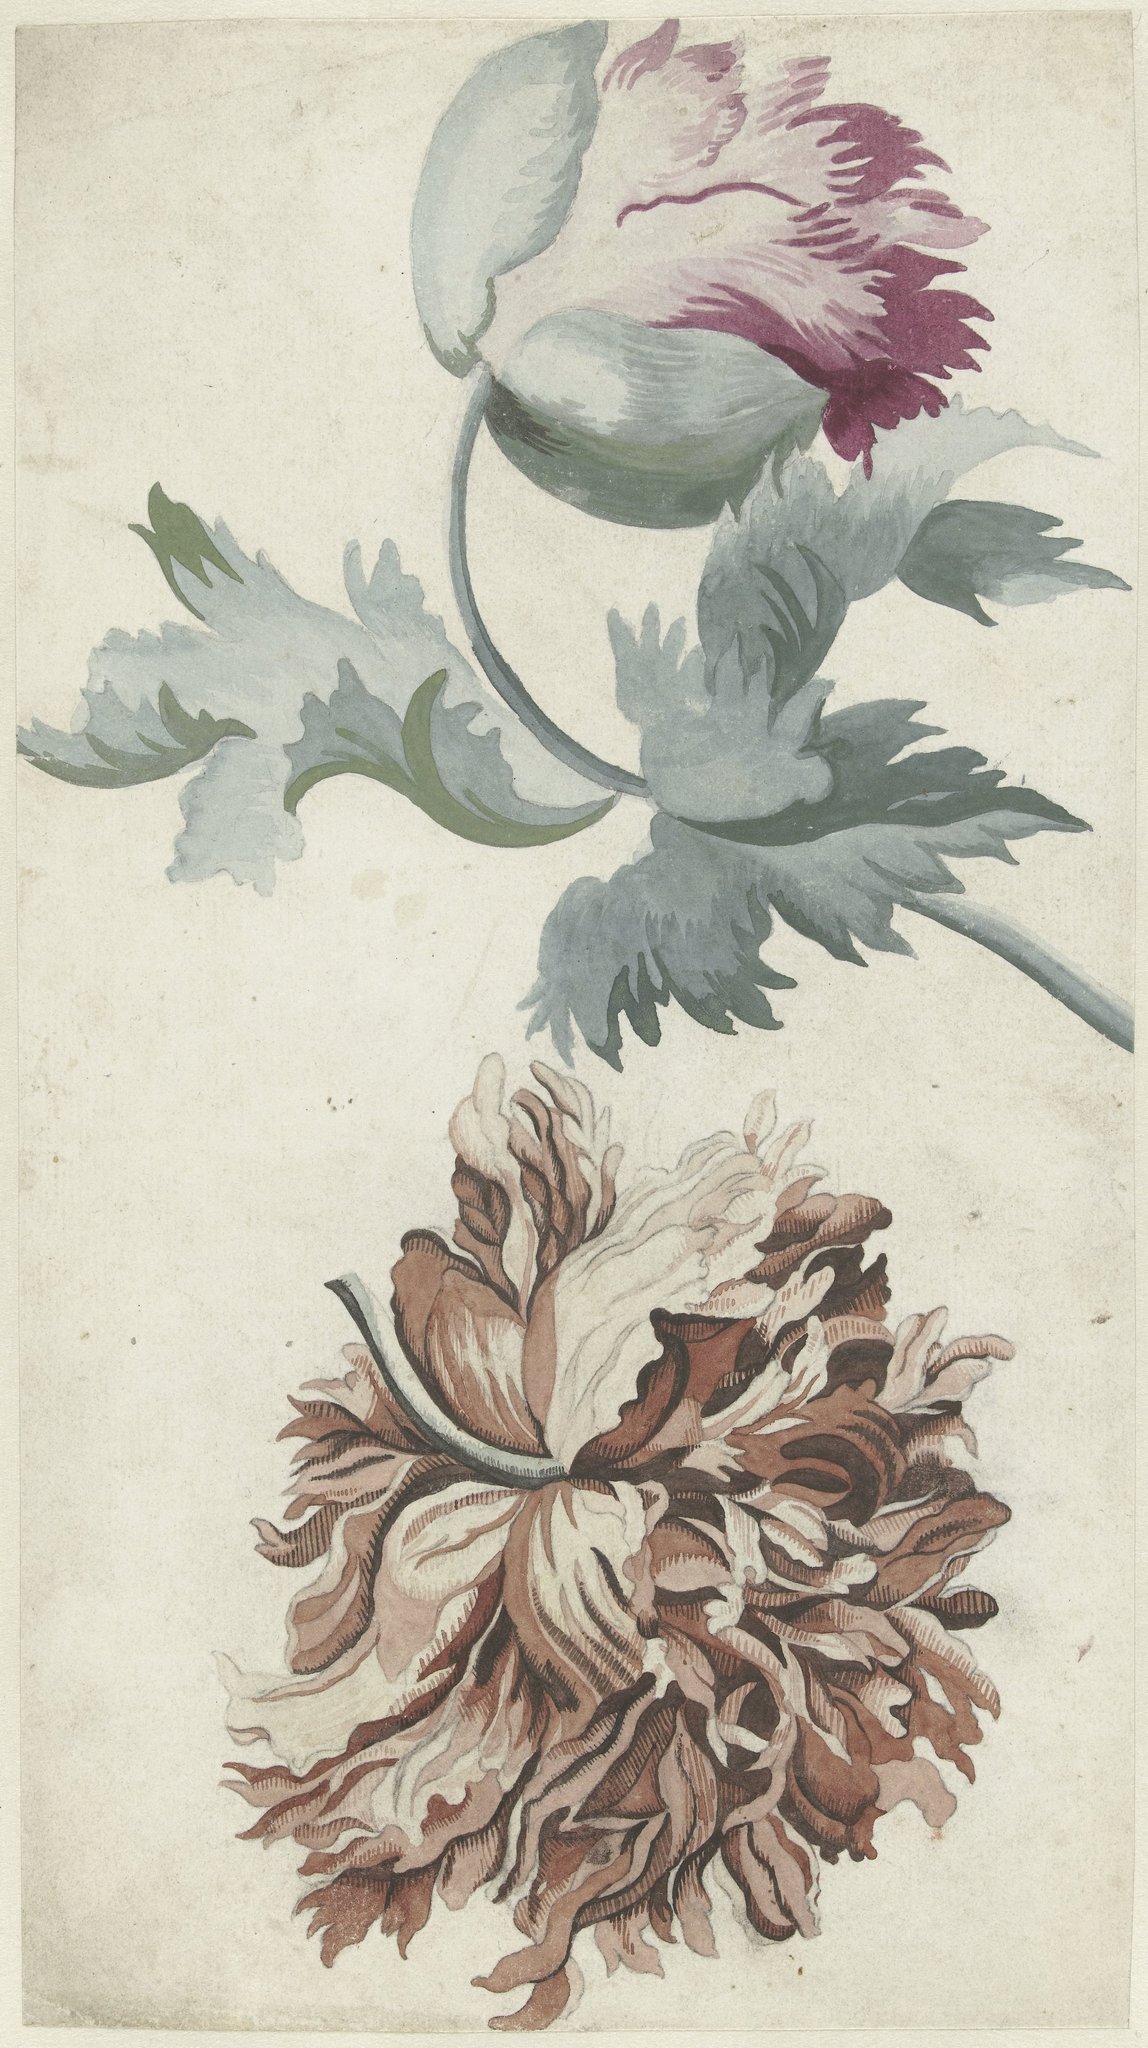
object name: watercolor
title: Papavers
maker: bernard picart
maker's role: draughtsman, print maker, publisher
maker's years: 1673-1733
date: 1683-1733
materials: chalk, paper, watercolor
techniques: brush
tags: flowers: poppy